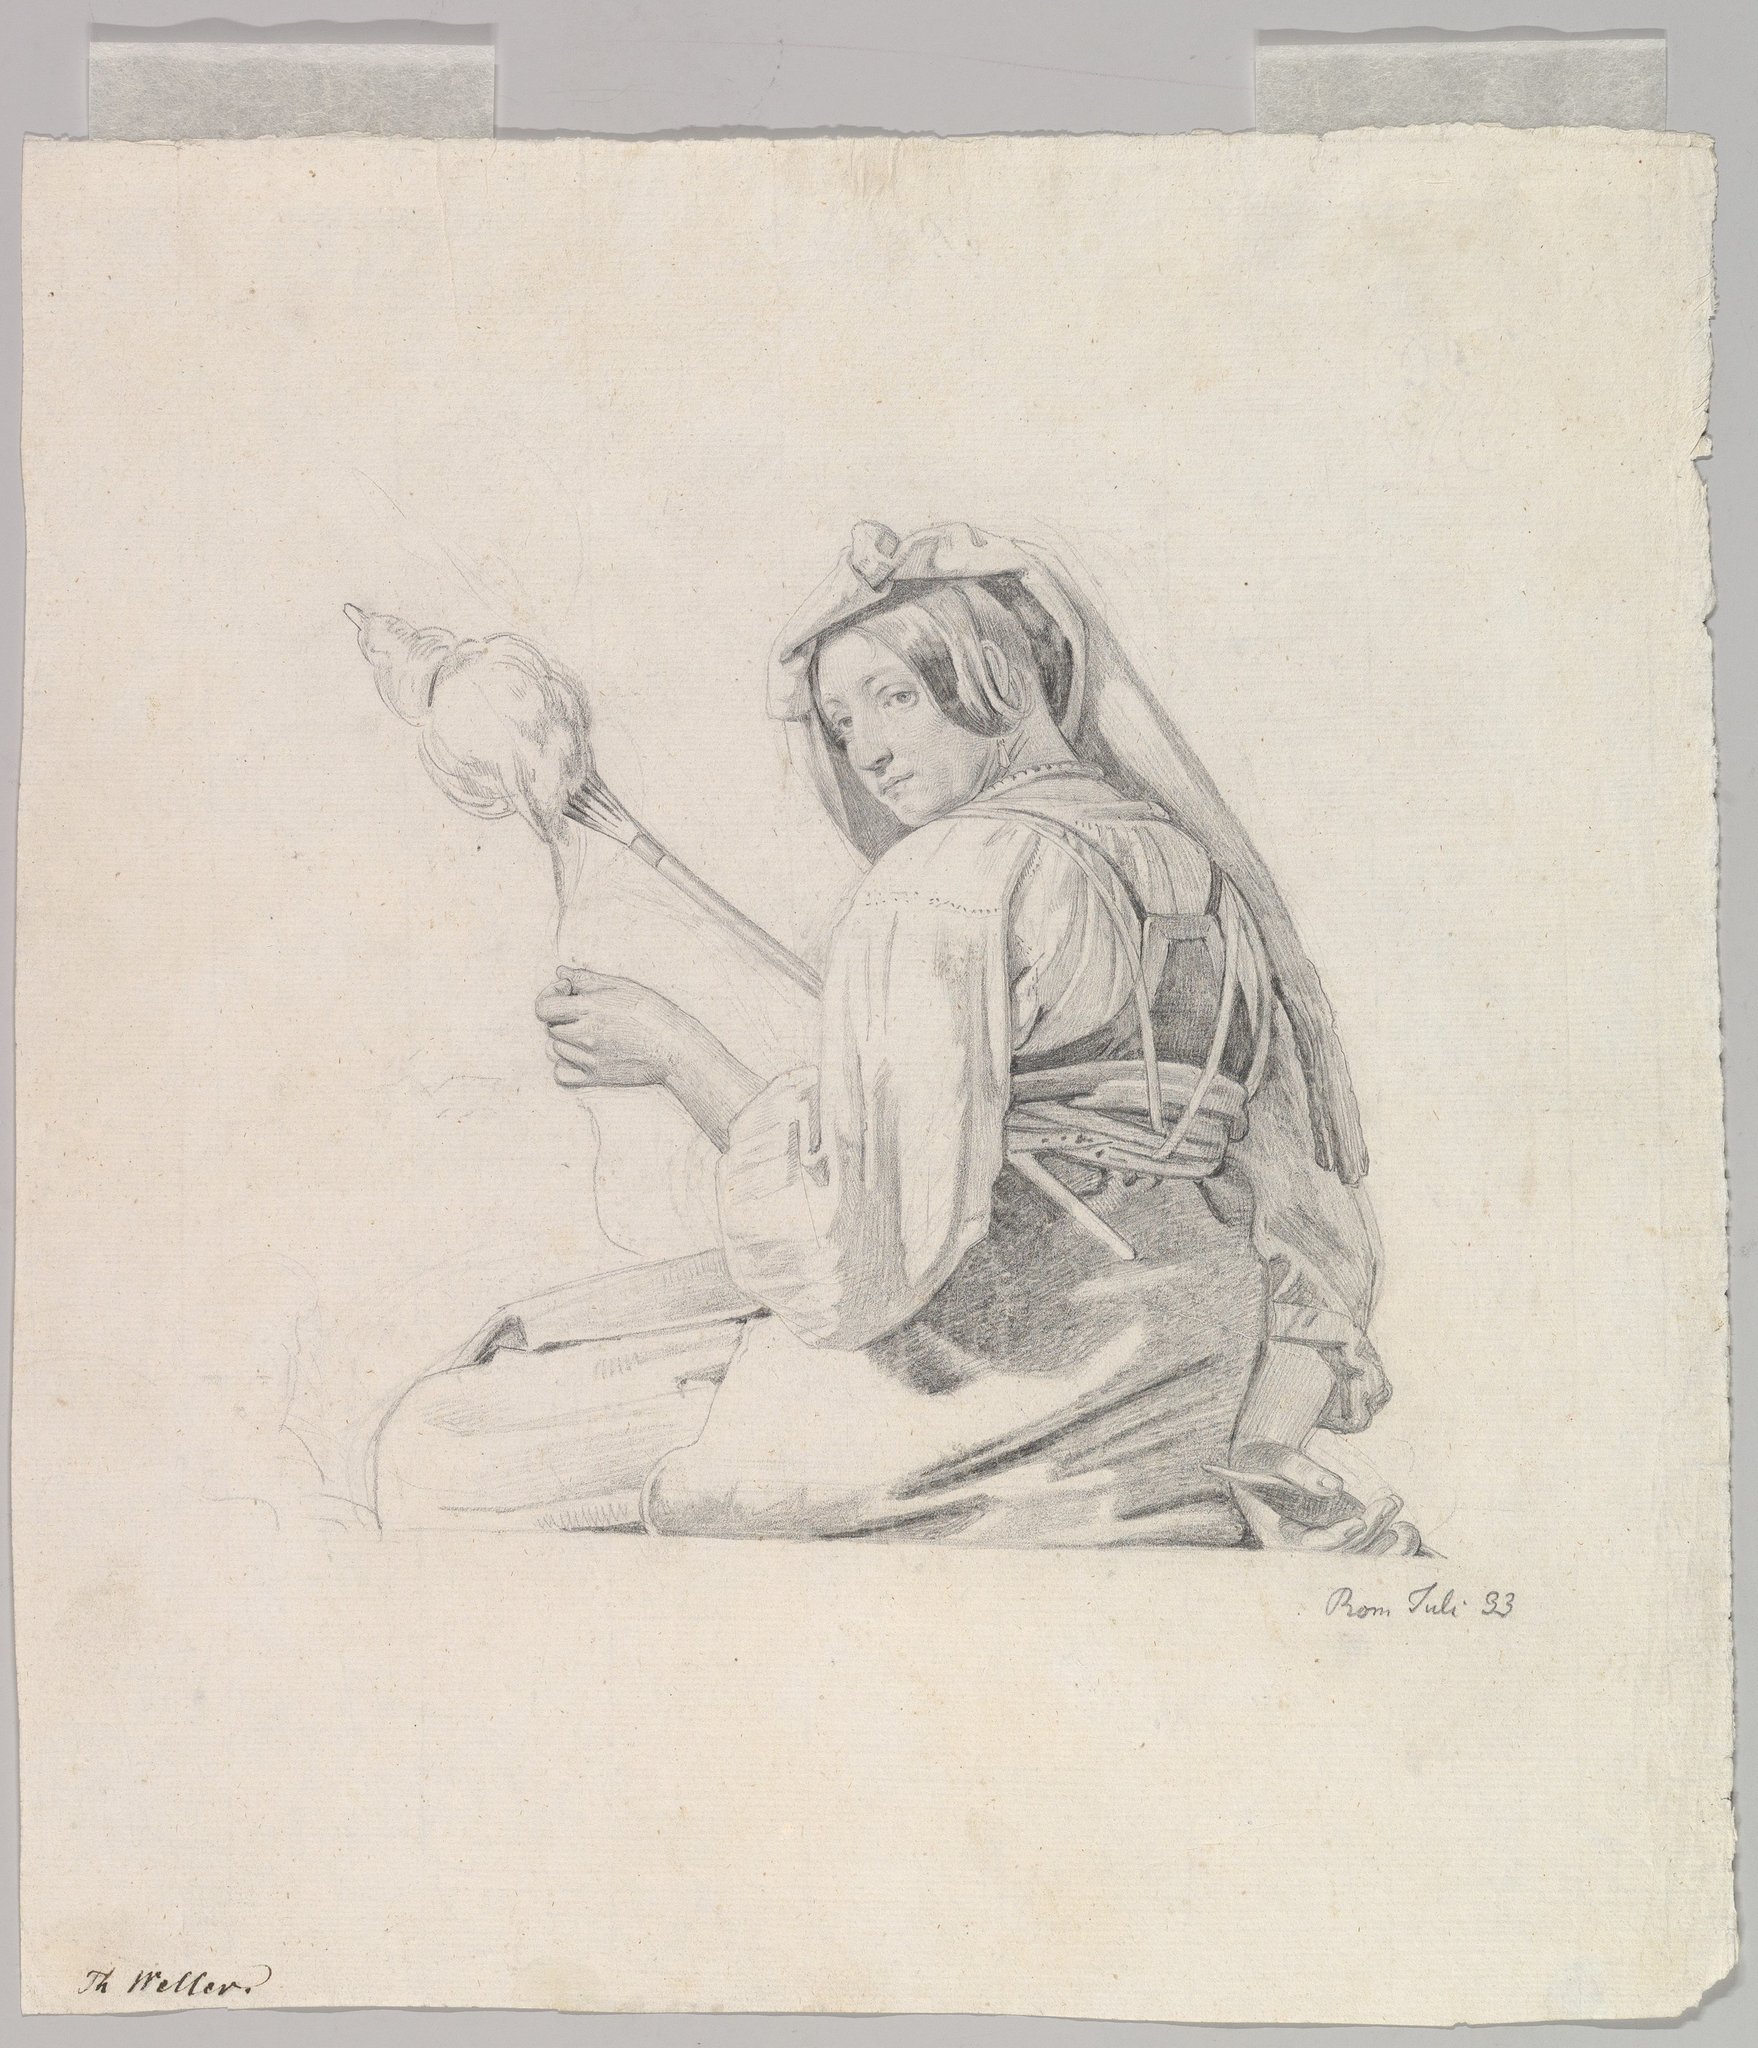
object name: drawing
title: A Seated Woman in Roman Dress, Spinning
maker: theodor leopold weller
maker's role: artist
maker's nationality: german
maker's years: 1802-1880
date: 1801-1900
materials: graphite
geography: germany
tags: women